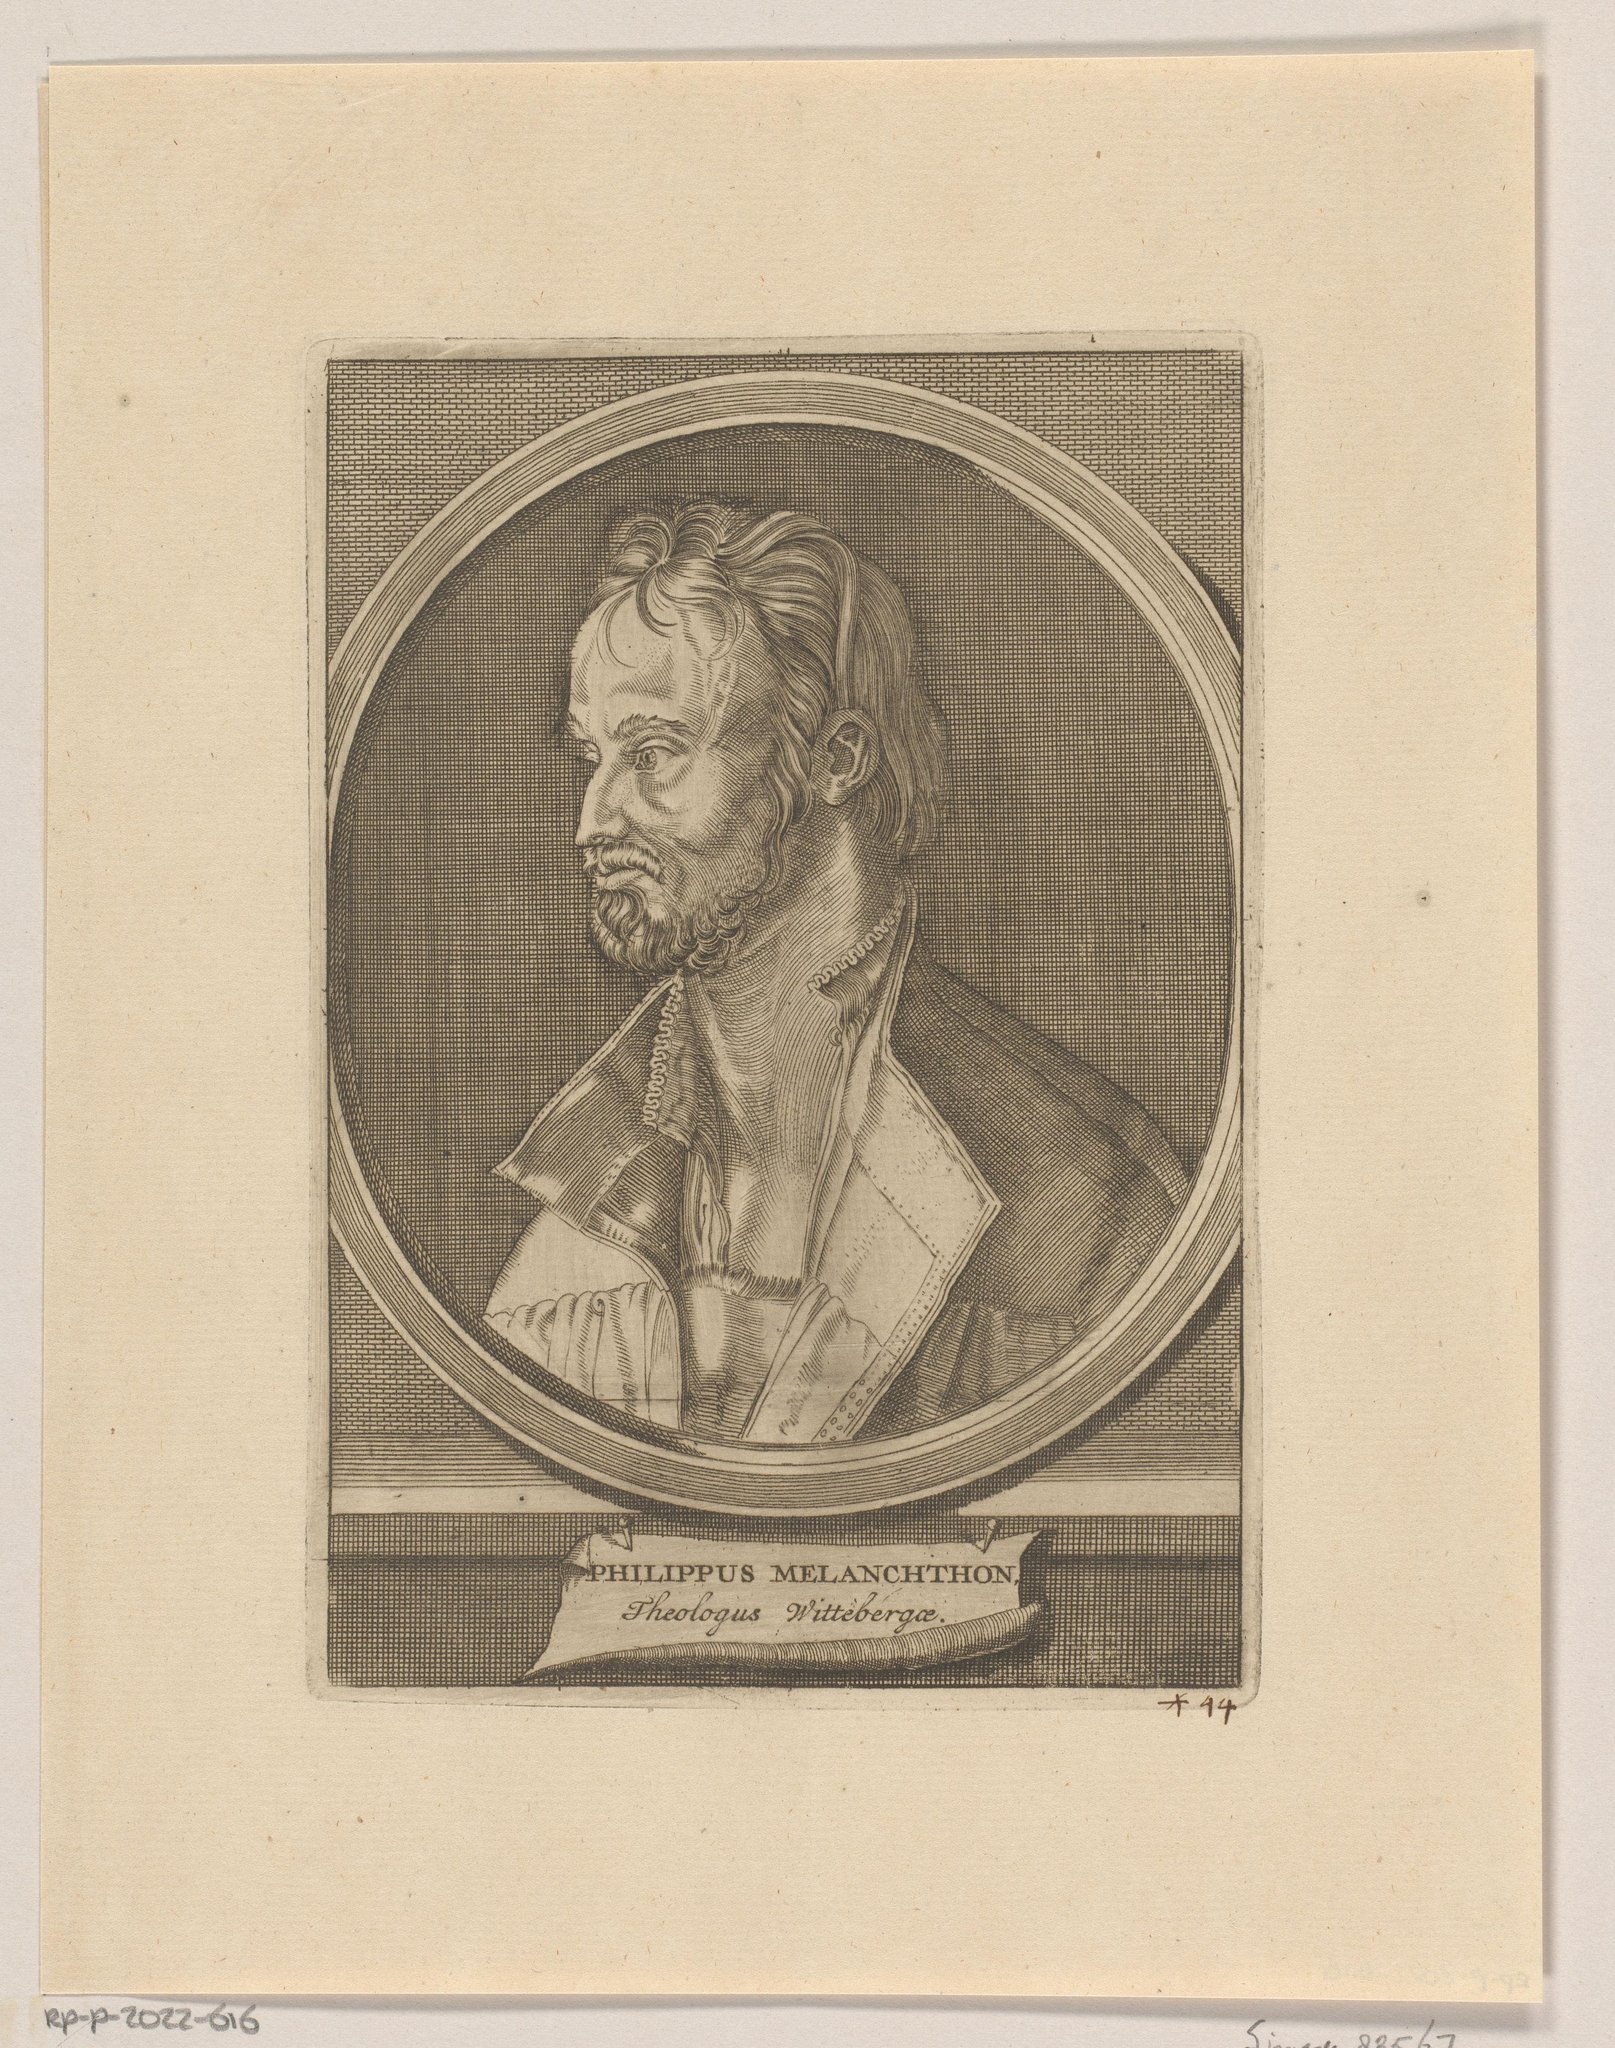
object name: print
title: Le miroir des portraits des premiers reformateurs des eglises protestantes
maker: hendrick hondius (i)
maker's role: draughtsman, print maker, publisher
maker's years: 1573-1650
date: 1690-1729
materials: paper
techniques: engraving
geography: the hague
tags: theologian, historical persons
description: Prent waarschijnlijk uit: s.n. Le miroir des portraits des premiers reformateurs des églises protestantes. Leiden: Pieter van der Aa, 1690-1729.